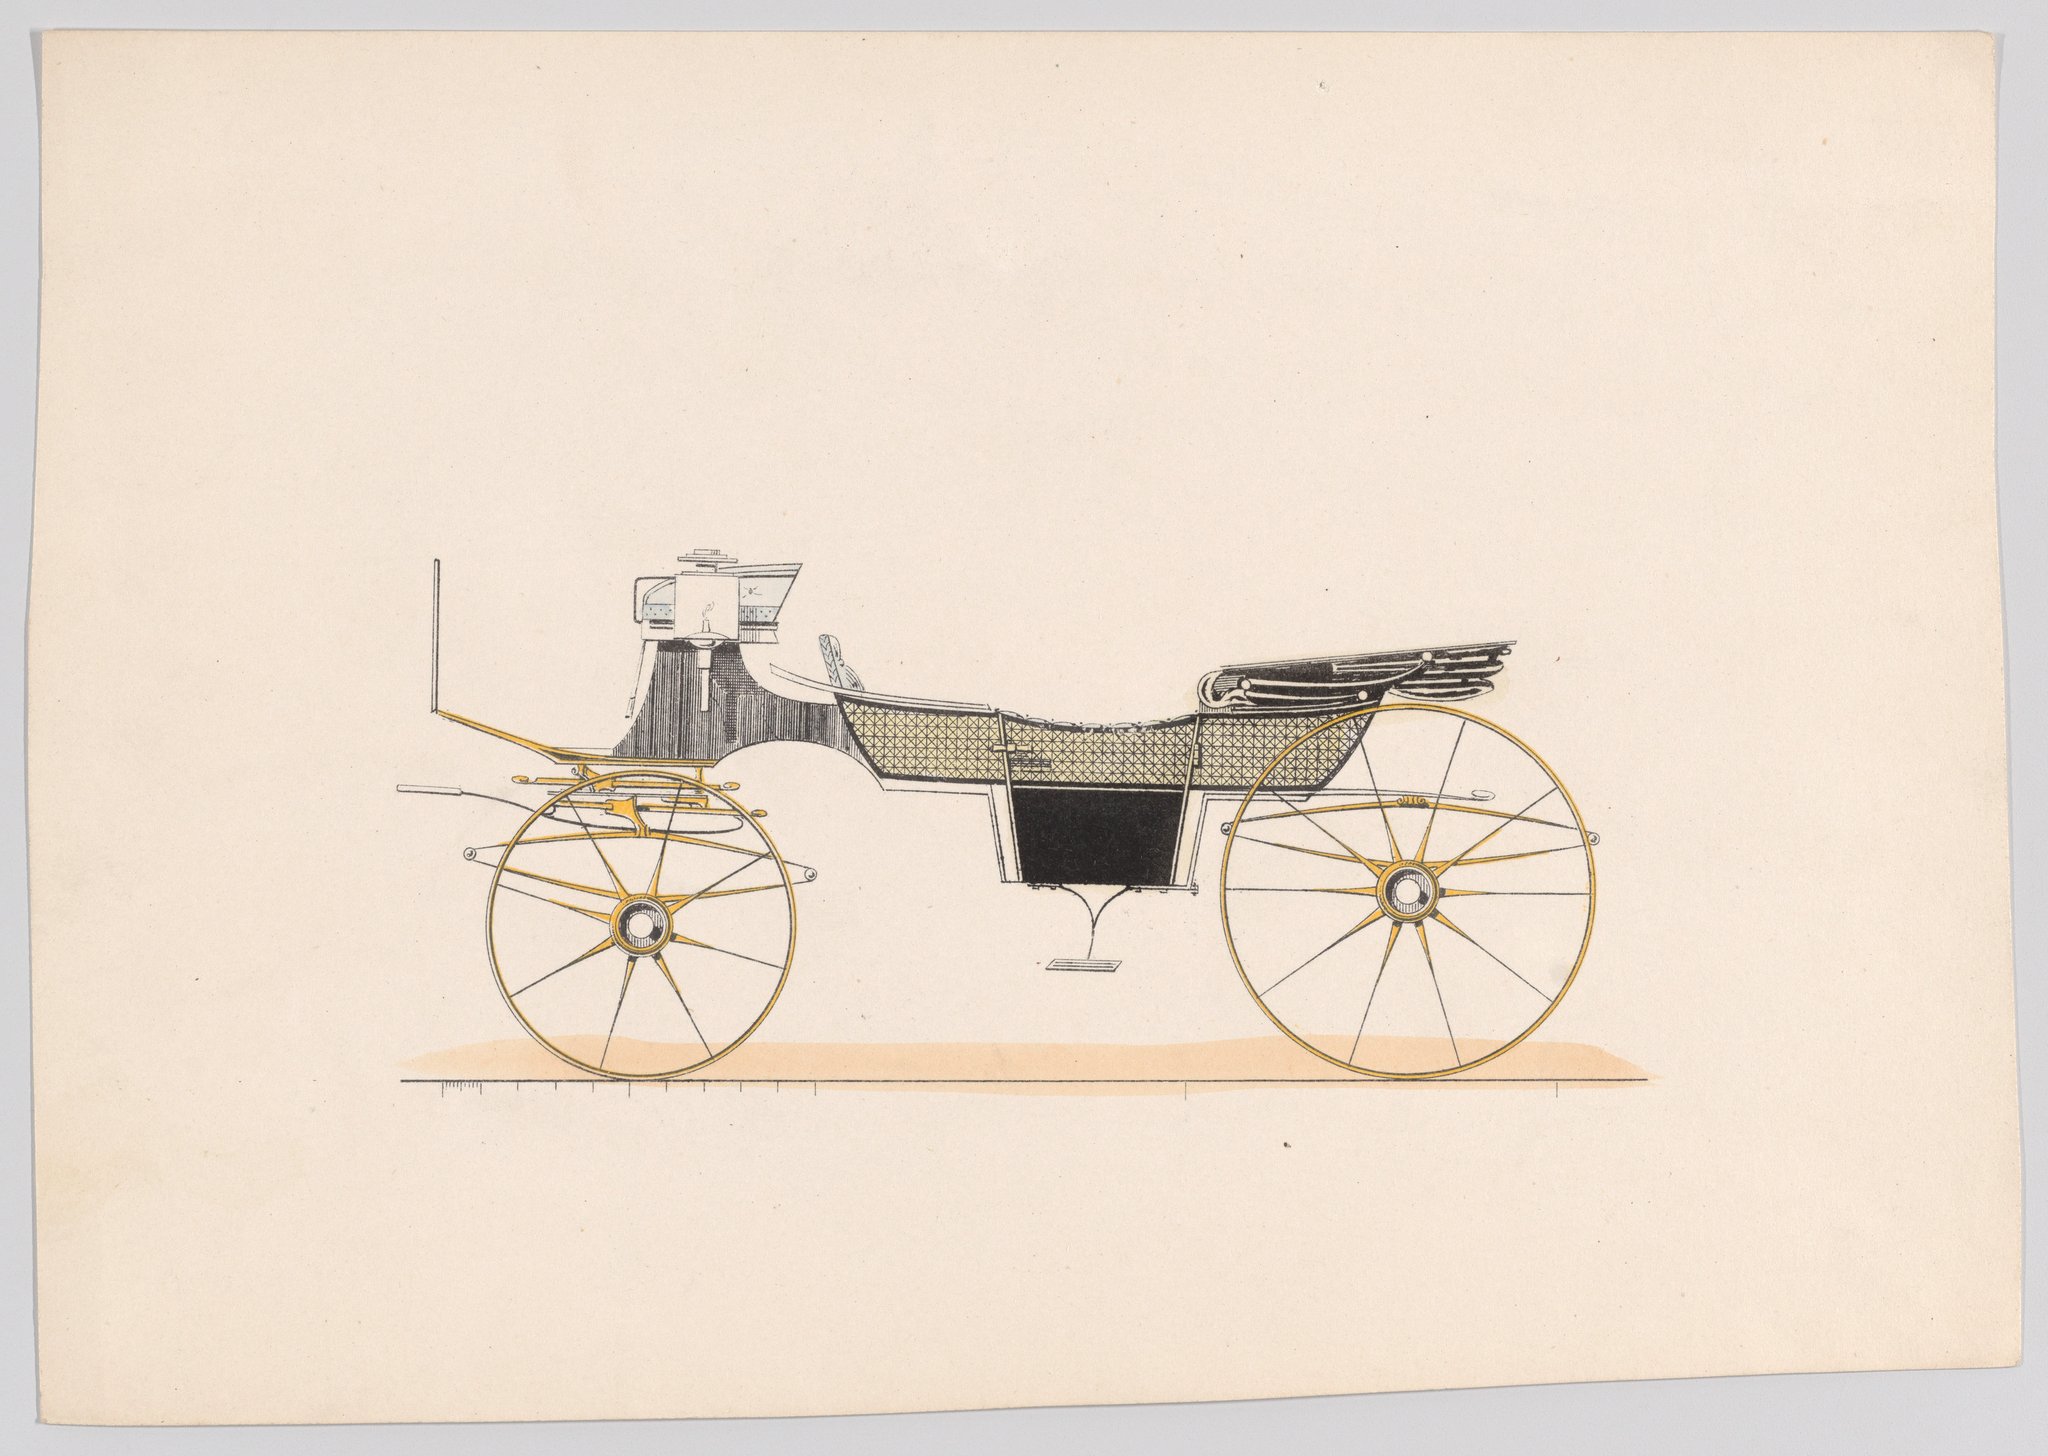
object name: print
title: Design for Vis-A-Vis/Sociable Carriage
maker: anonymous, french, 19th century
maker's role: artist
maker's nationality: french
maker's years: 1800-1900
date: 1870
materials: gum arabic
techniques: hand coloring, lithograph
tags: carriages